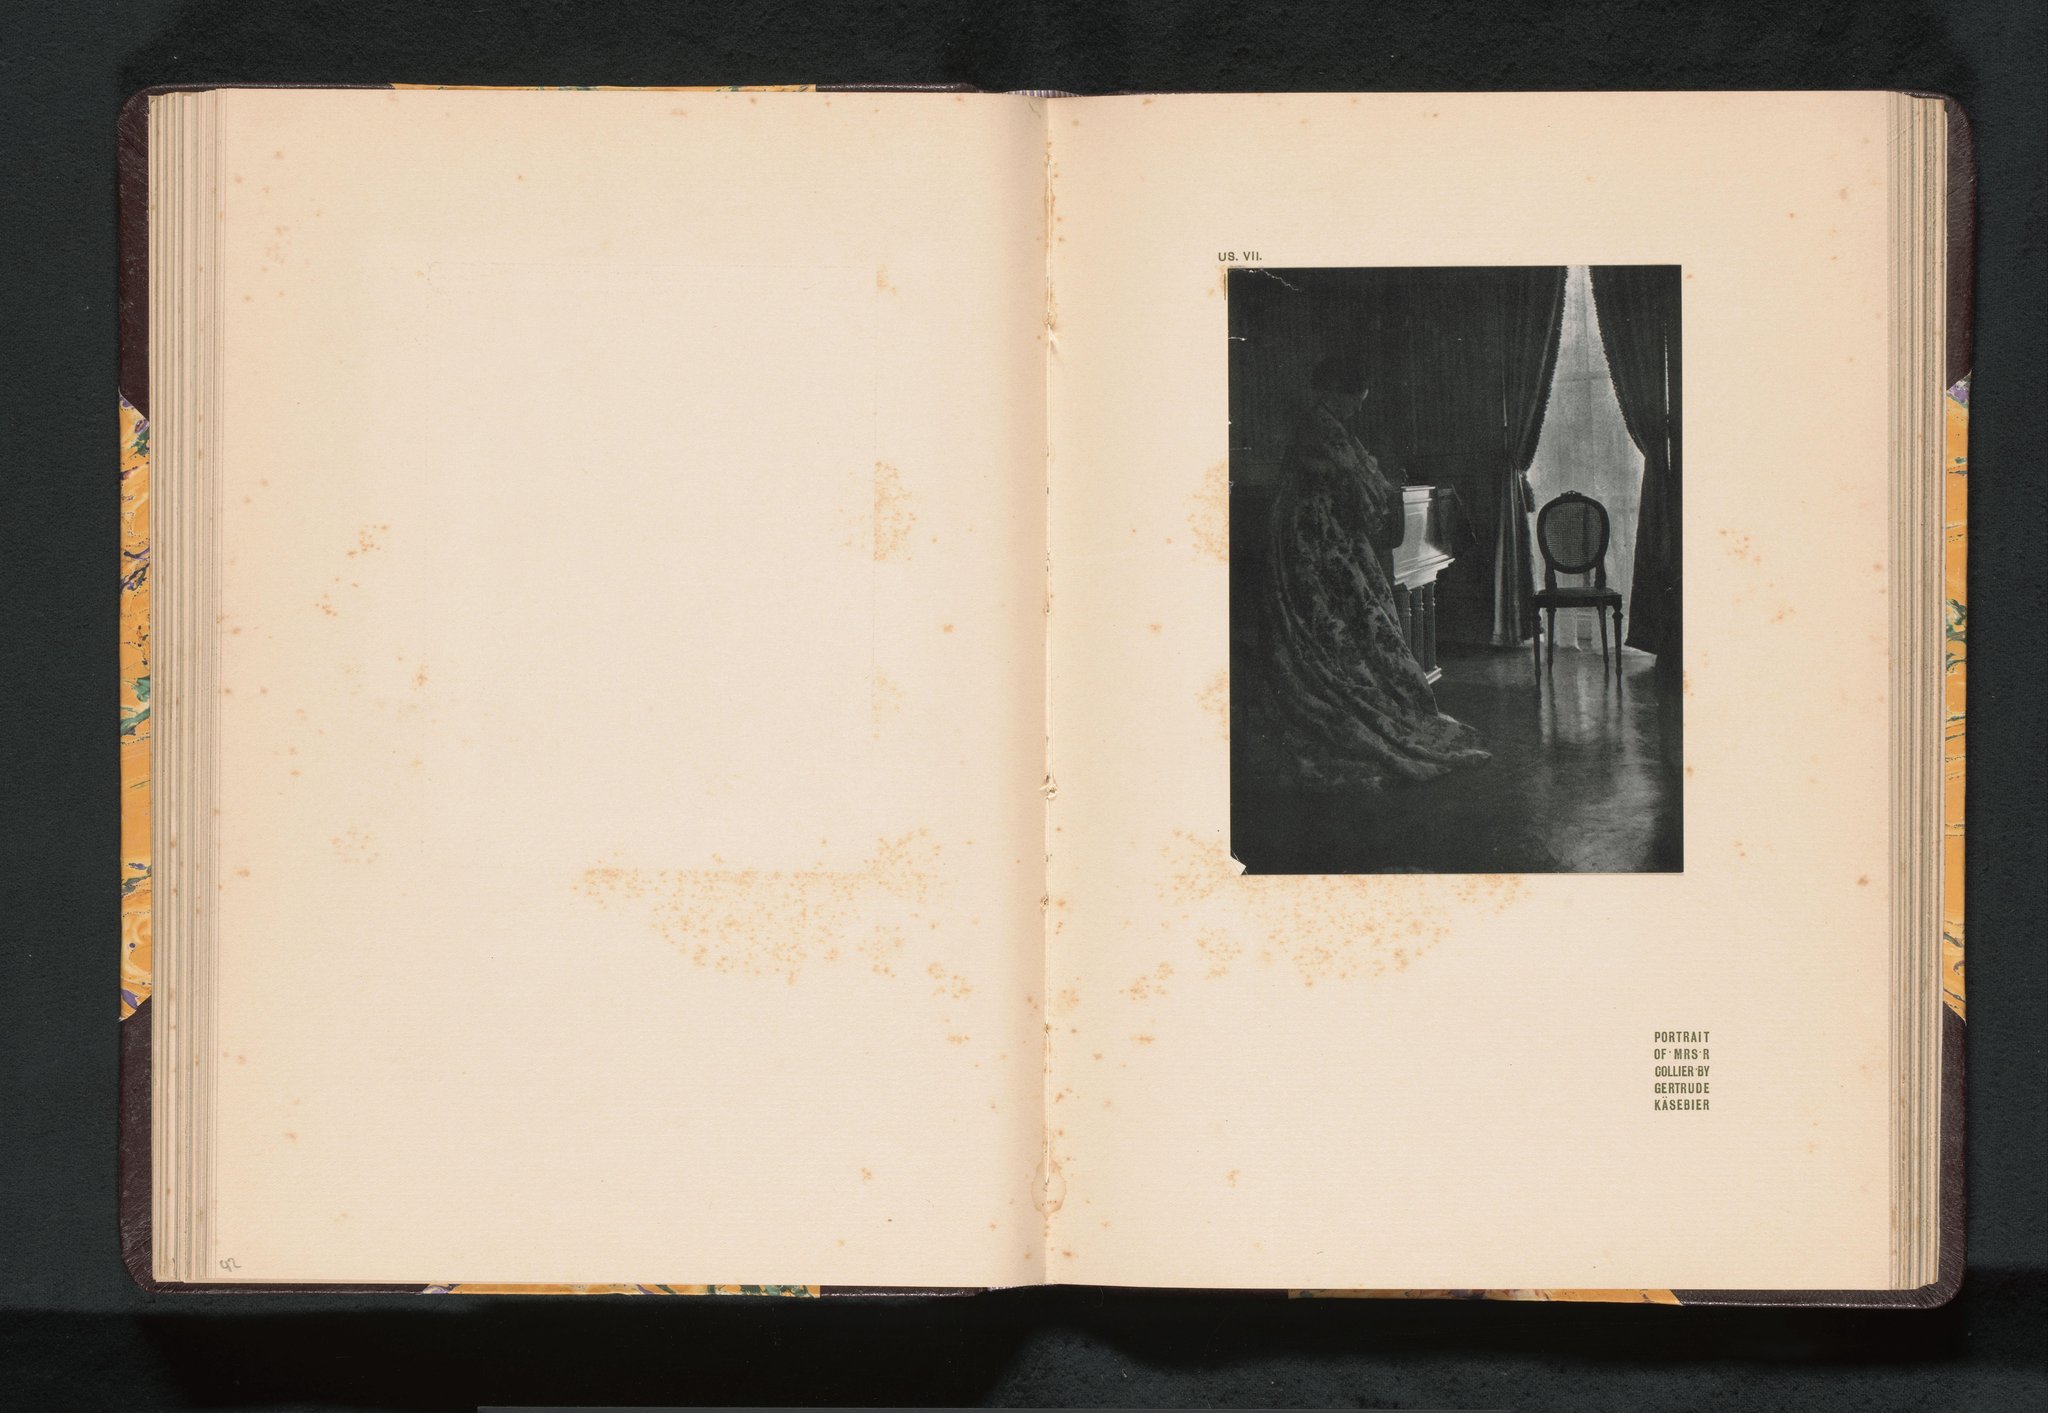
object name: page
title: Portret van een onbekende vrouw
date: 1900-1905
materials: paper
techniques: two-color autotype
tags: historical persons - bb - woman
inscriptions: inscription: ‘Portrait of Mrs R. Collier by Gertrude Käsebier’, inscription: ‘US. VII.’